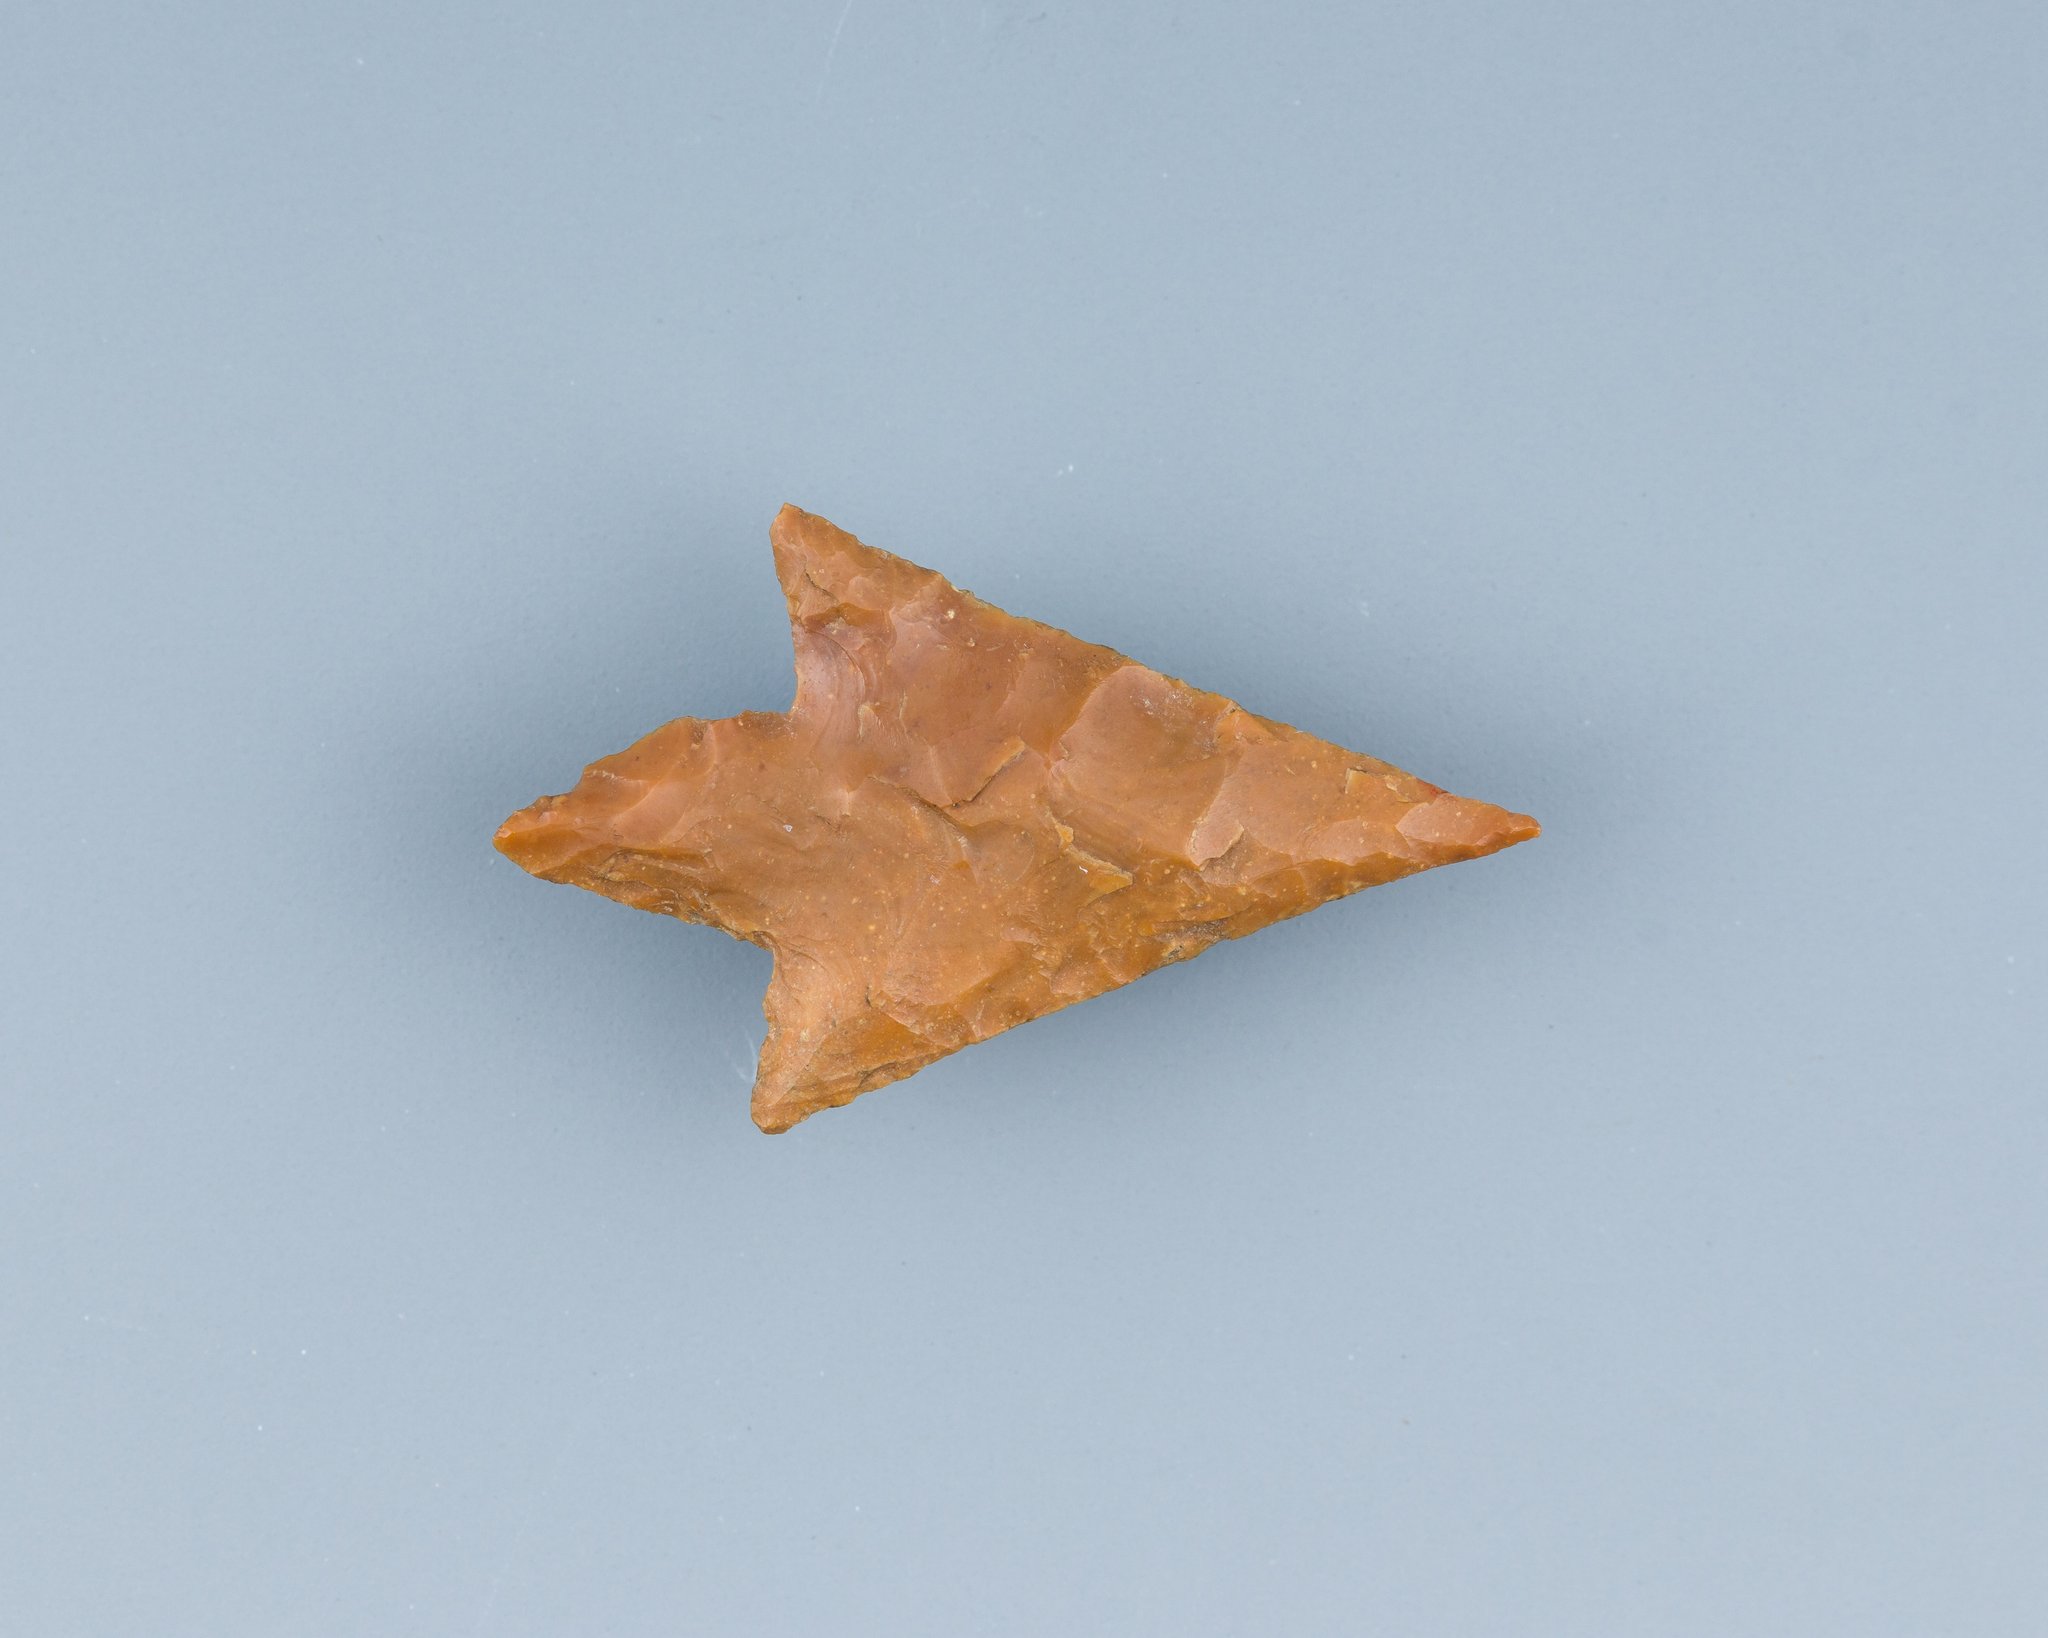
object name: arrowhead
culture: italian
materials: stone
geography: italy